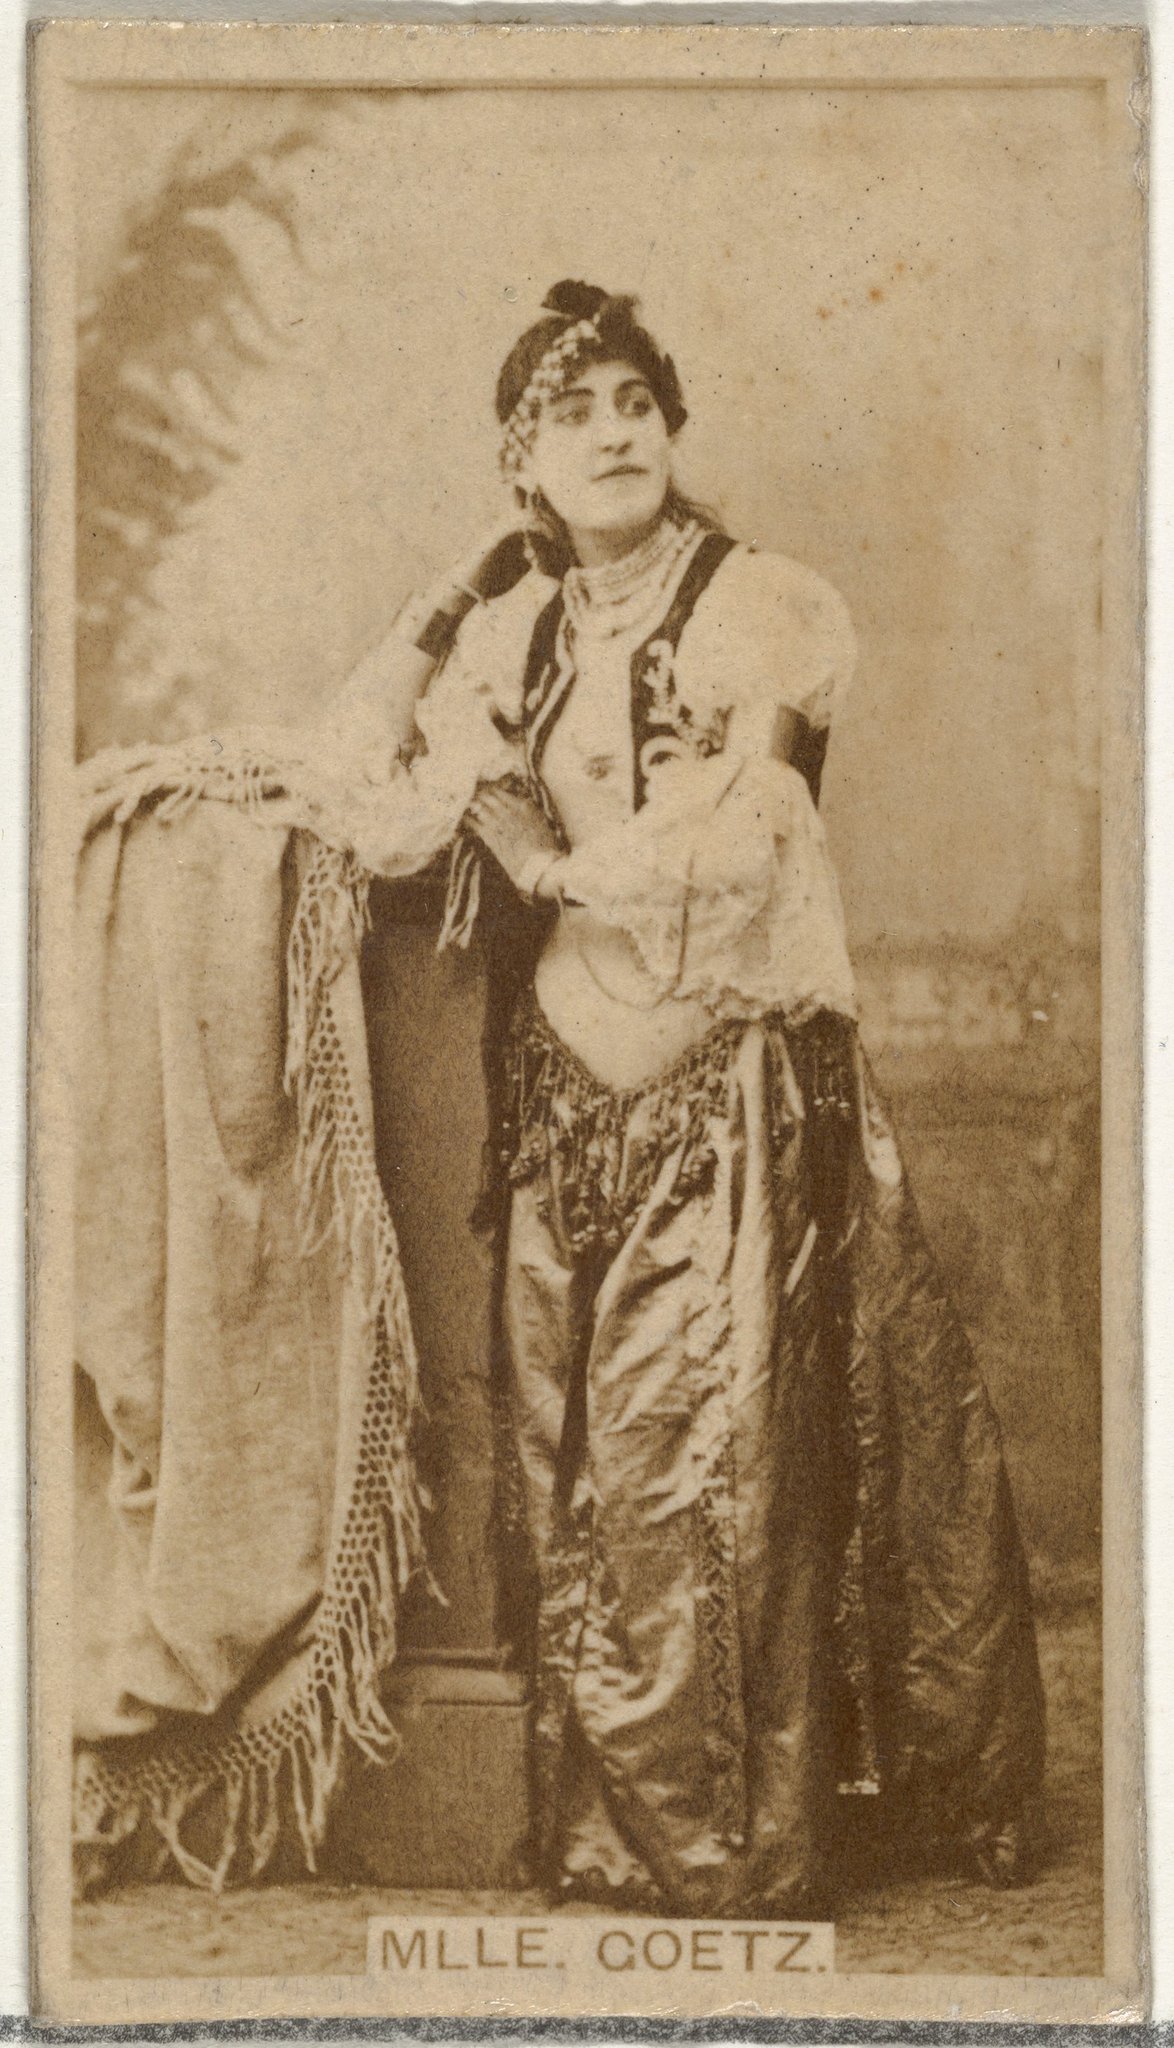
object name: photograph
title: Mlle. Goetz, from the Actors and Actresses series (N145-8) issued by Duke Sons & Co. to promote Duke Cigarettes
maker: w. duke, sons & co.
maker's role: publisher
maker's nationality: american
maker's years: 1870-1920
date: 1891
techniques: albumen silver print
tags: portraits,women,actresses